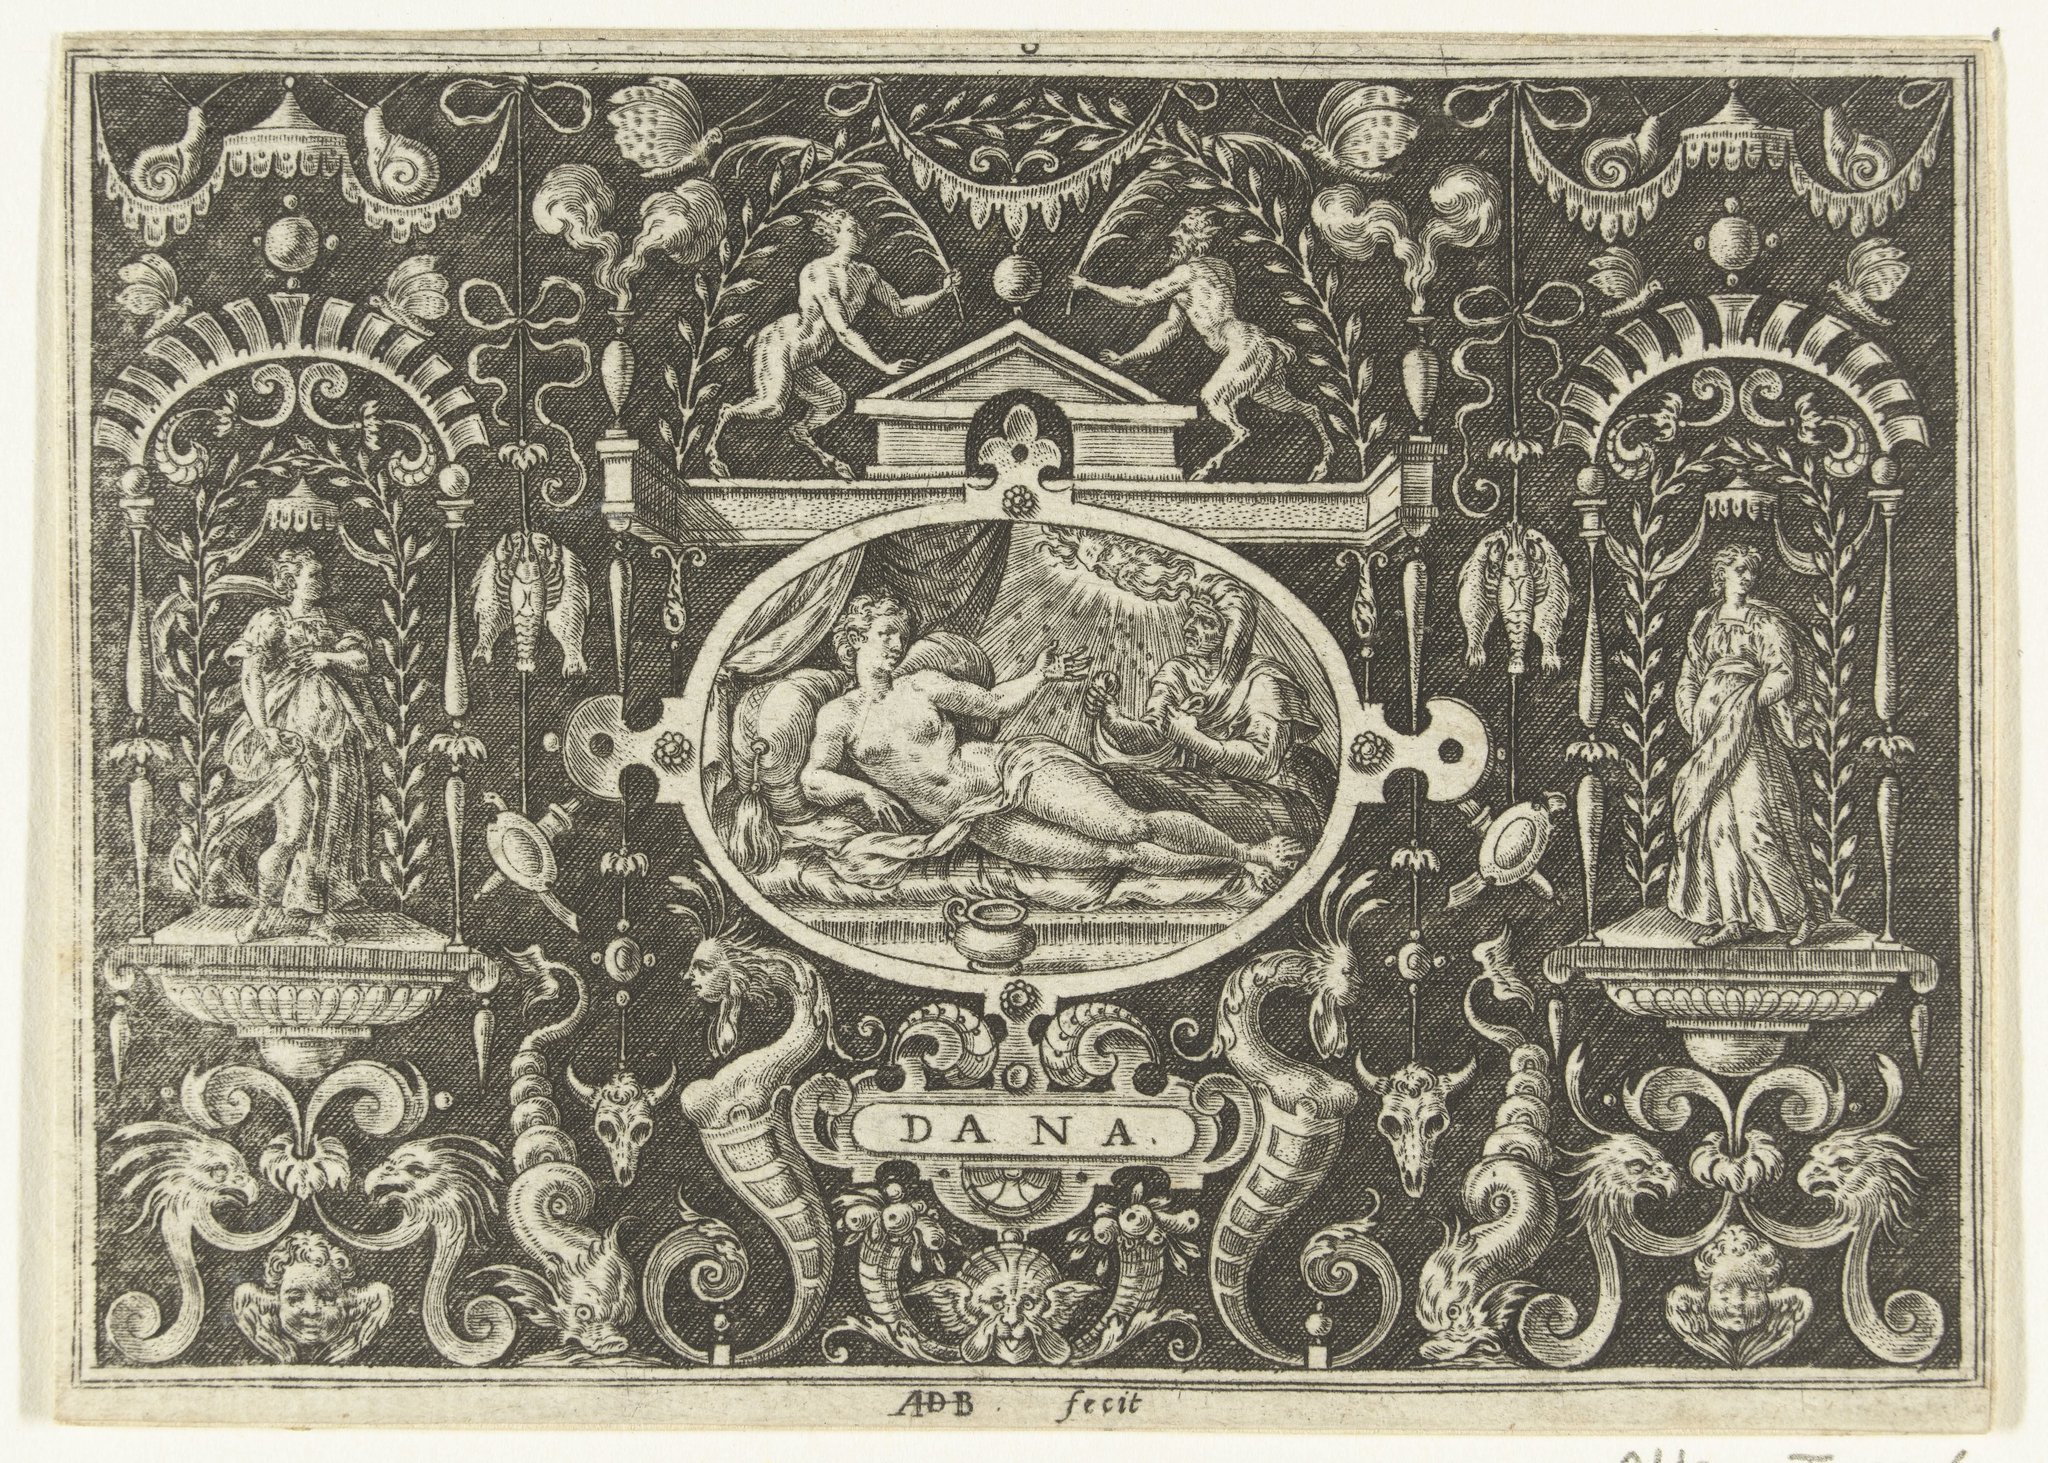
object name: print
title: Ovale cartouches met voorstellingen uit het leven van Perseus in omlijsting van grotesken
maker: abraham de bruyn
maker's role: print maker, publisher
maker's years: 1540-1587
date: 1584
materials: paper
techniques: engraving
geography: netherlands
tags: ornament ~ grotesque, ornament ~ cartouche, jupiter wooing danae; she is usually lying in bed receiving a shower of gold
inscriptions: signature: ‘ADB fecit’, title: ‘DANA’, number: ‘6’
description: Jupiter, vermomd als gouden regen, verwekt Perseus bij Danaë. Zij ligt op een hemelbed. In de omlijsting links en rechts van de cartouche een vrouw onder een baldakijn.